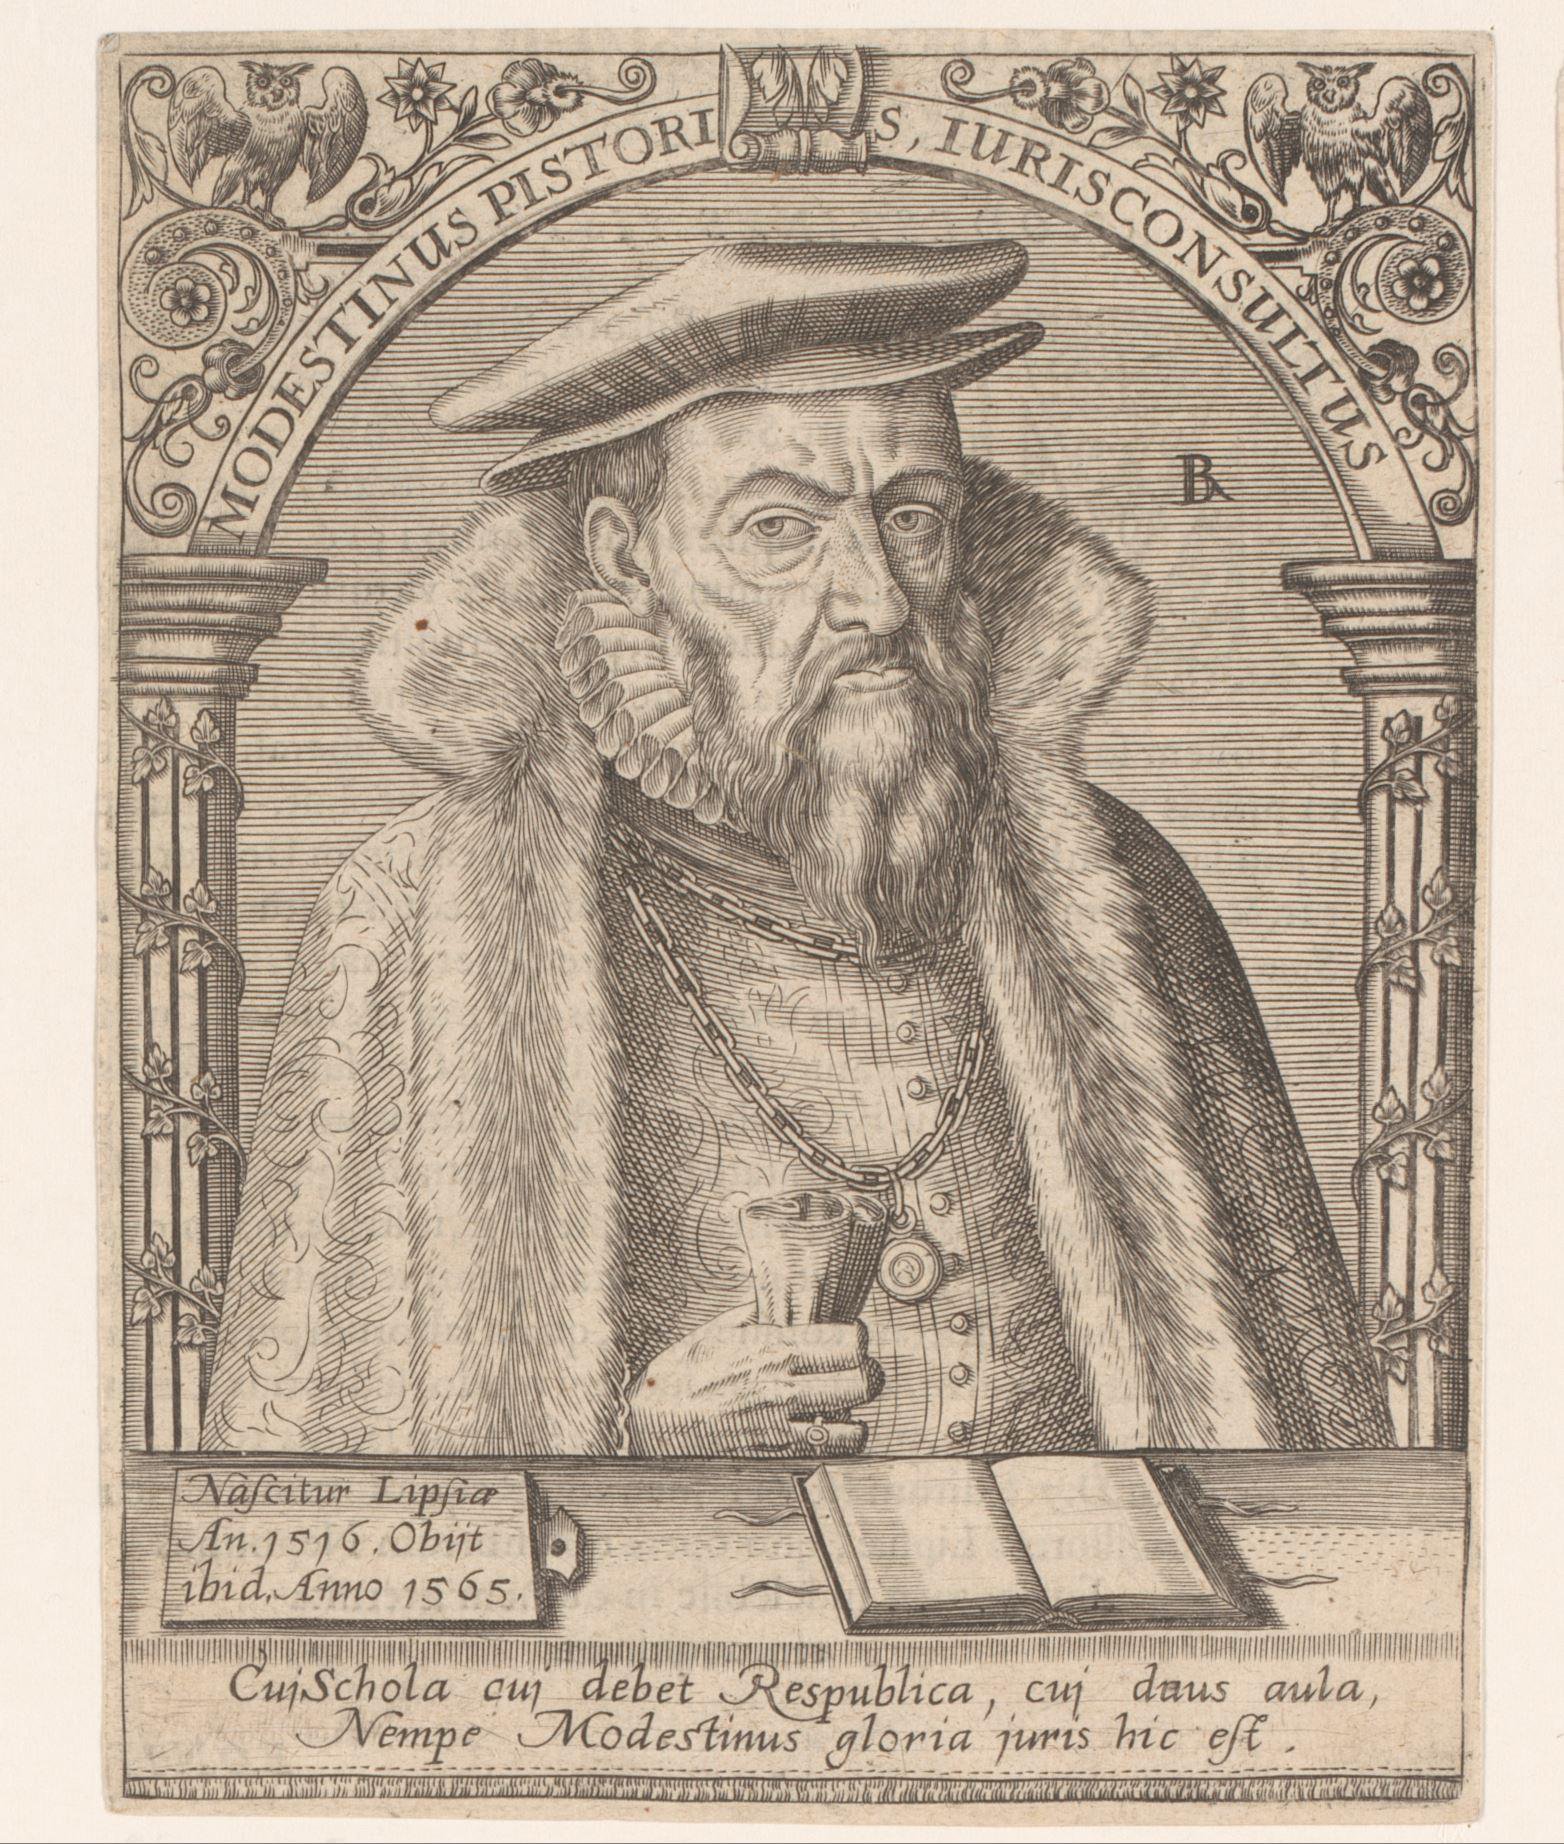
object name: print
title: Portret van Modestinus Pistoris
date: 1597-1599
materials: paper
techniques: engraving, letterpress printing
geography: france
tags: historical persons, book, fabulous animals ~ owls